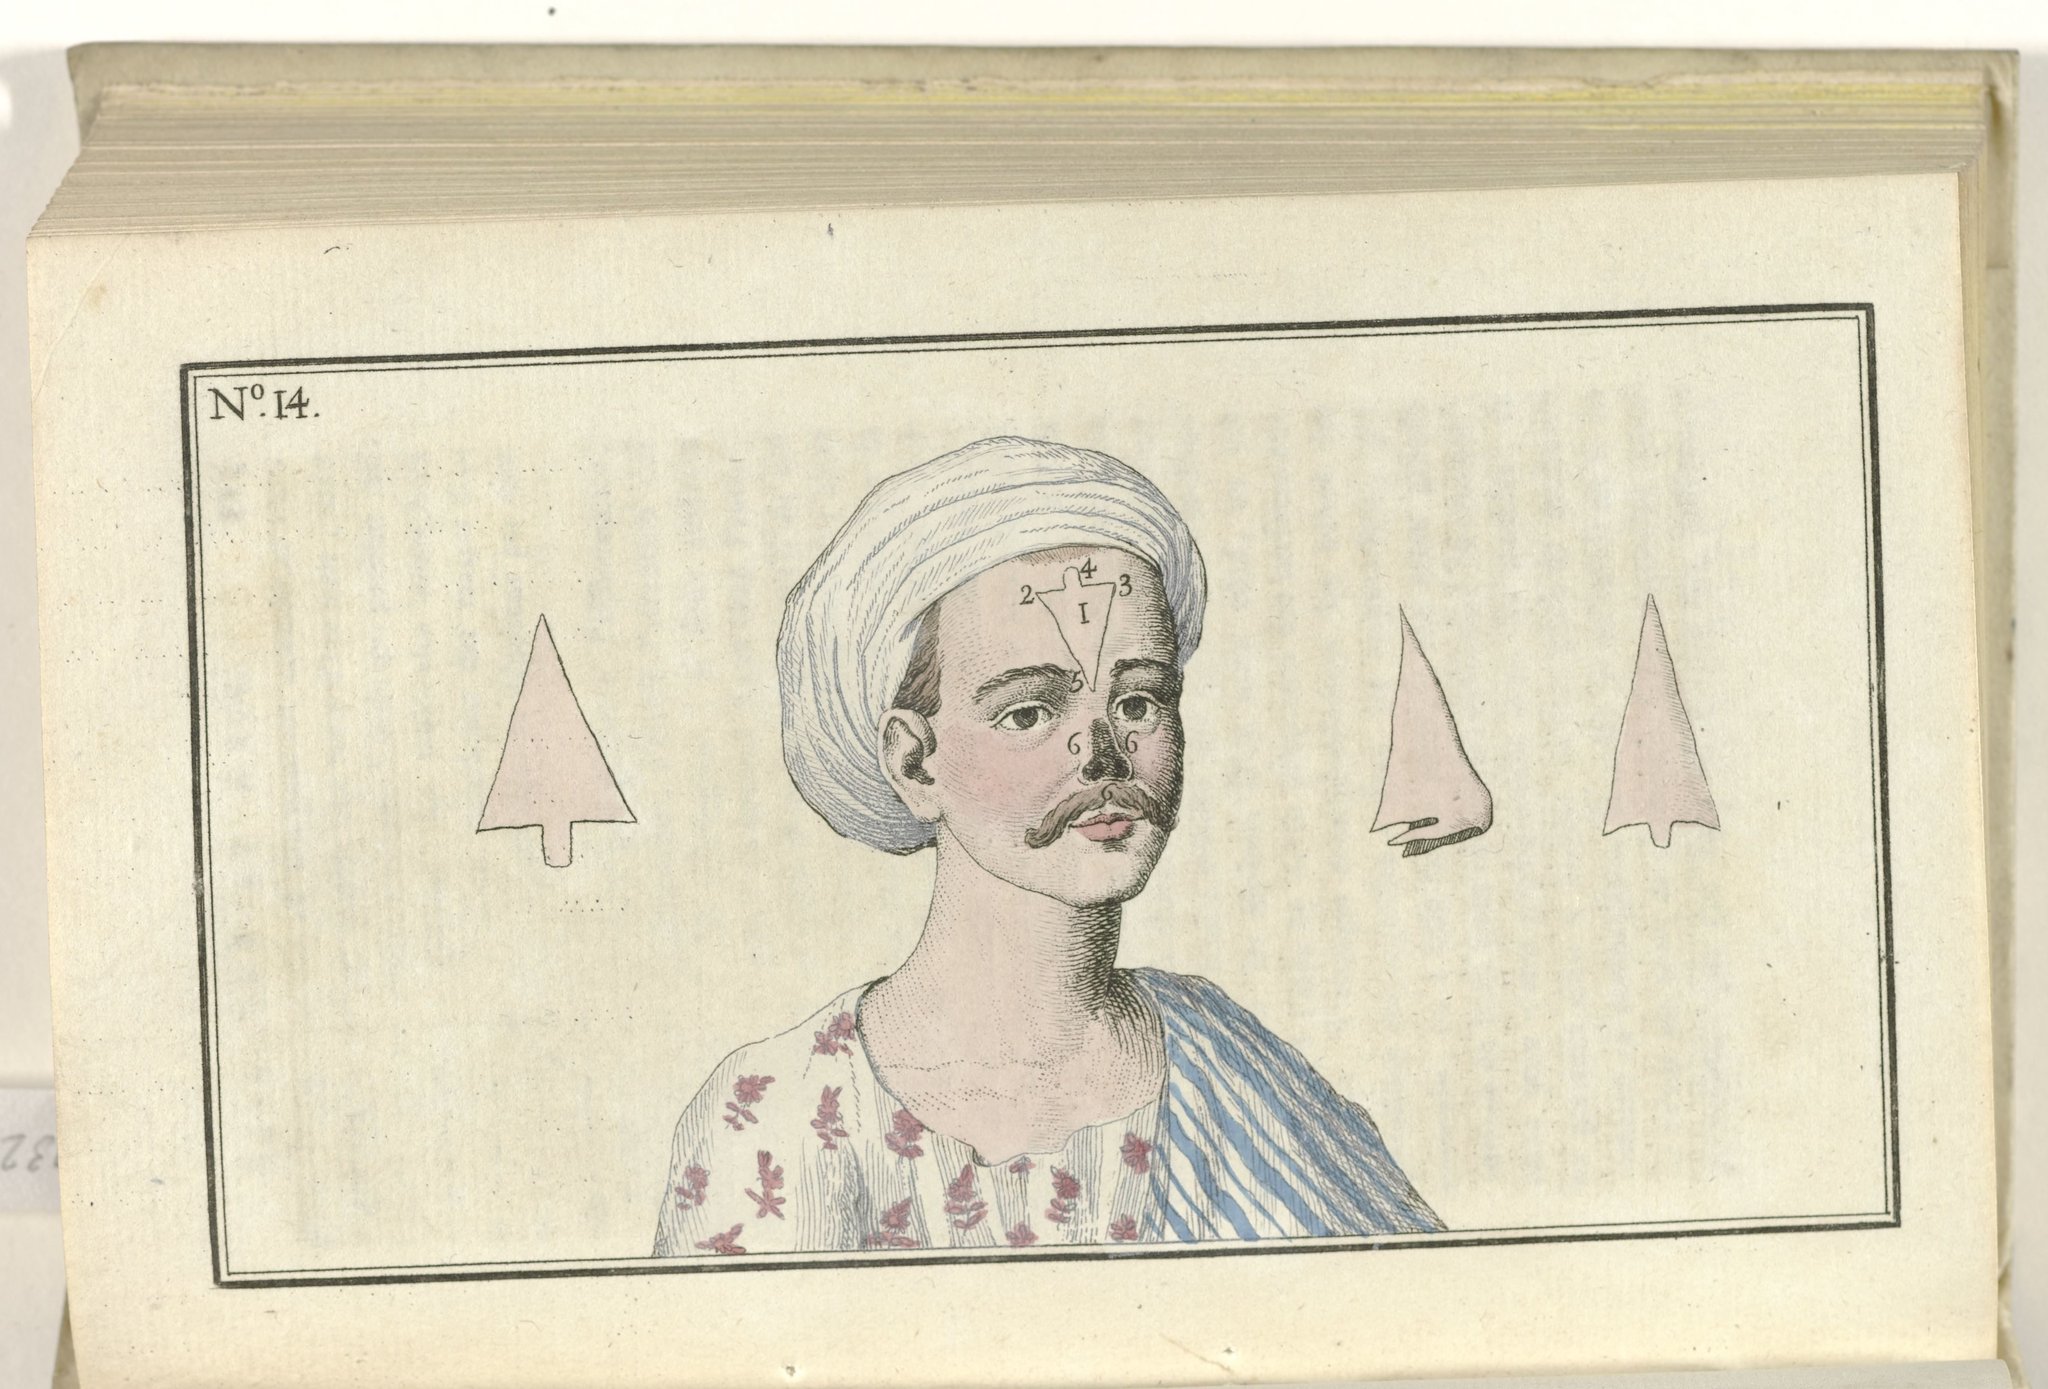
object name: print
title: Le Mois, Journal historique, littéraire et critique, avec figures, no. 14: Chirurgie: Opération singuliere pratique aux Indes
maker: Anonymous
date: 1800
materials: paper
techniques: etching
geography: théâtre des folies-marigny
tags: operation, surgery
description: Gezicht, waarop tekening voor operatie. Prent uit het tijdschrift Le mois : journal historique, littéraire et critique avec figures, 1800.